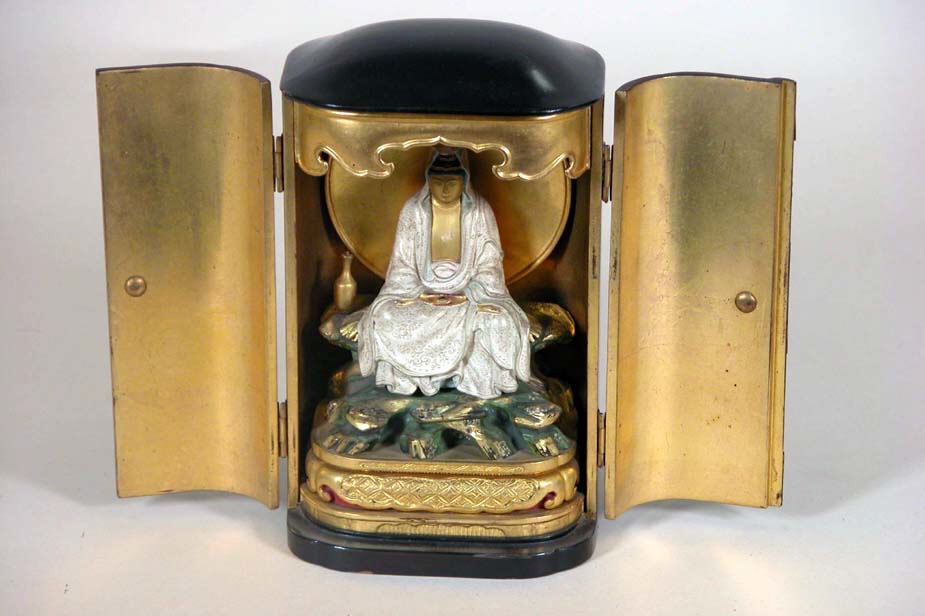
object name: shrine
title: Portable Shrine (zushi) with Byakue Kannon, the White-robed Bodhisattva of Compassion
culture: japanese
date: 1801-1900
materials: gold, lacquer, metal, pigment, wood